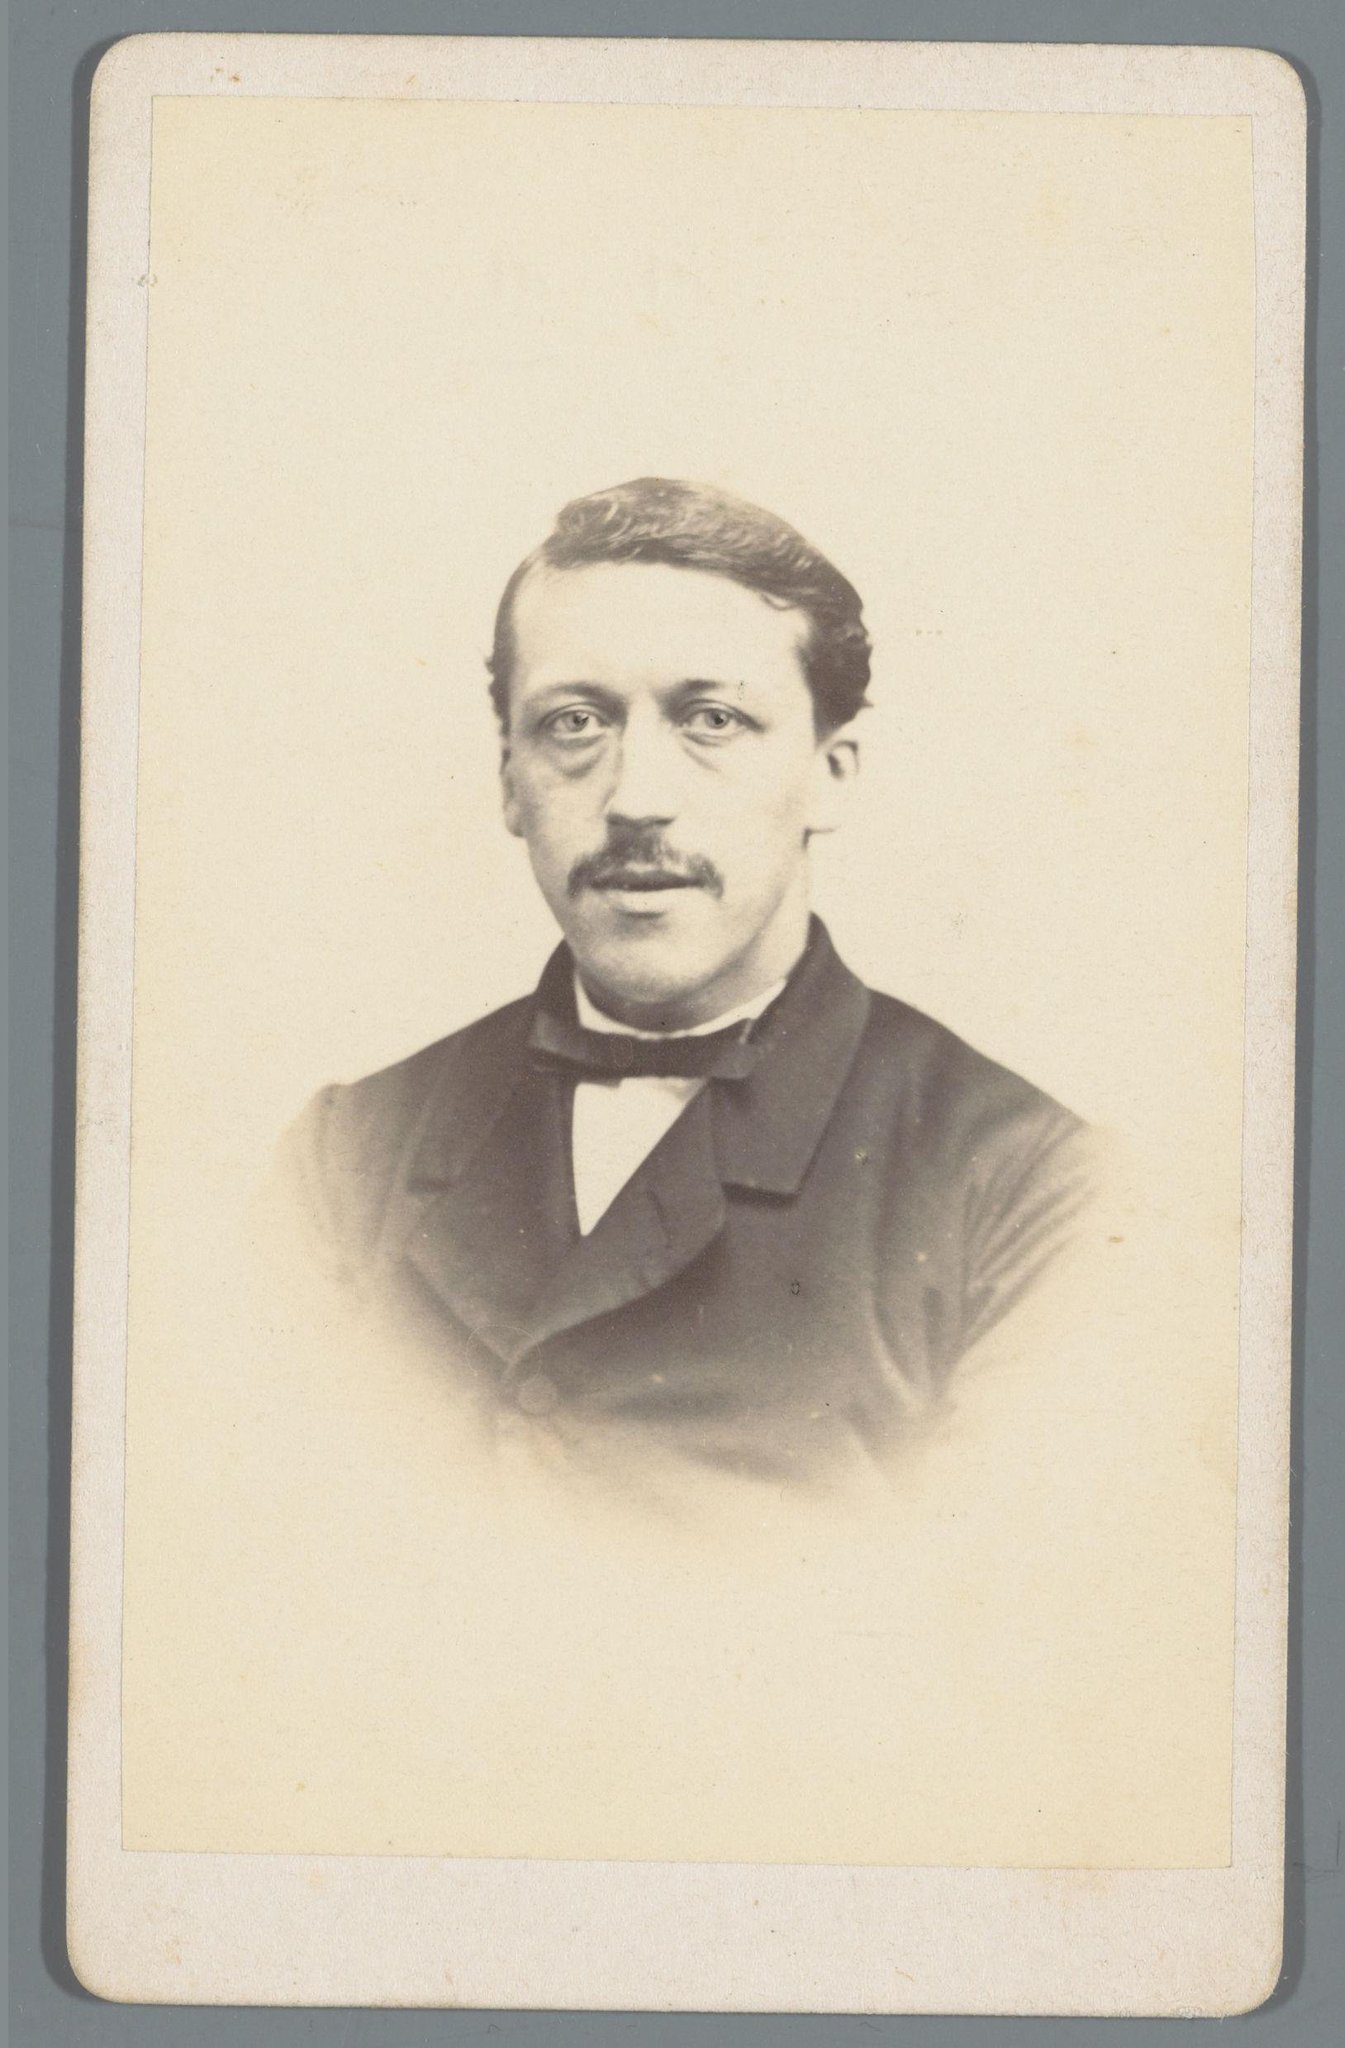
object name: carte de visite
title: Portret van een onbekende man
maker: antonius godefridus schull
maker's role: fotograaf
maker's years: 1819-1896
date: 1860-1885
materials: cardboard, paper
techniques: albumen print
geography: den bosch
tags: adult man, historical persons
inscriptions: inscription: ‘A. G. SCHULL/ KUNSTSCHILDER/ 's Bosch/ Kerkstraat.’